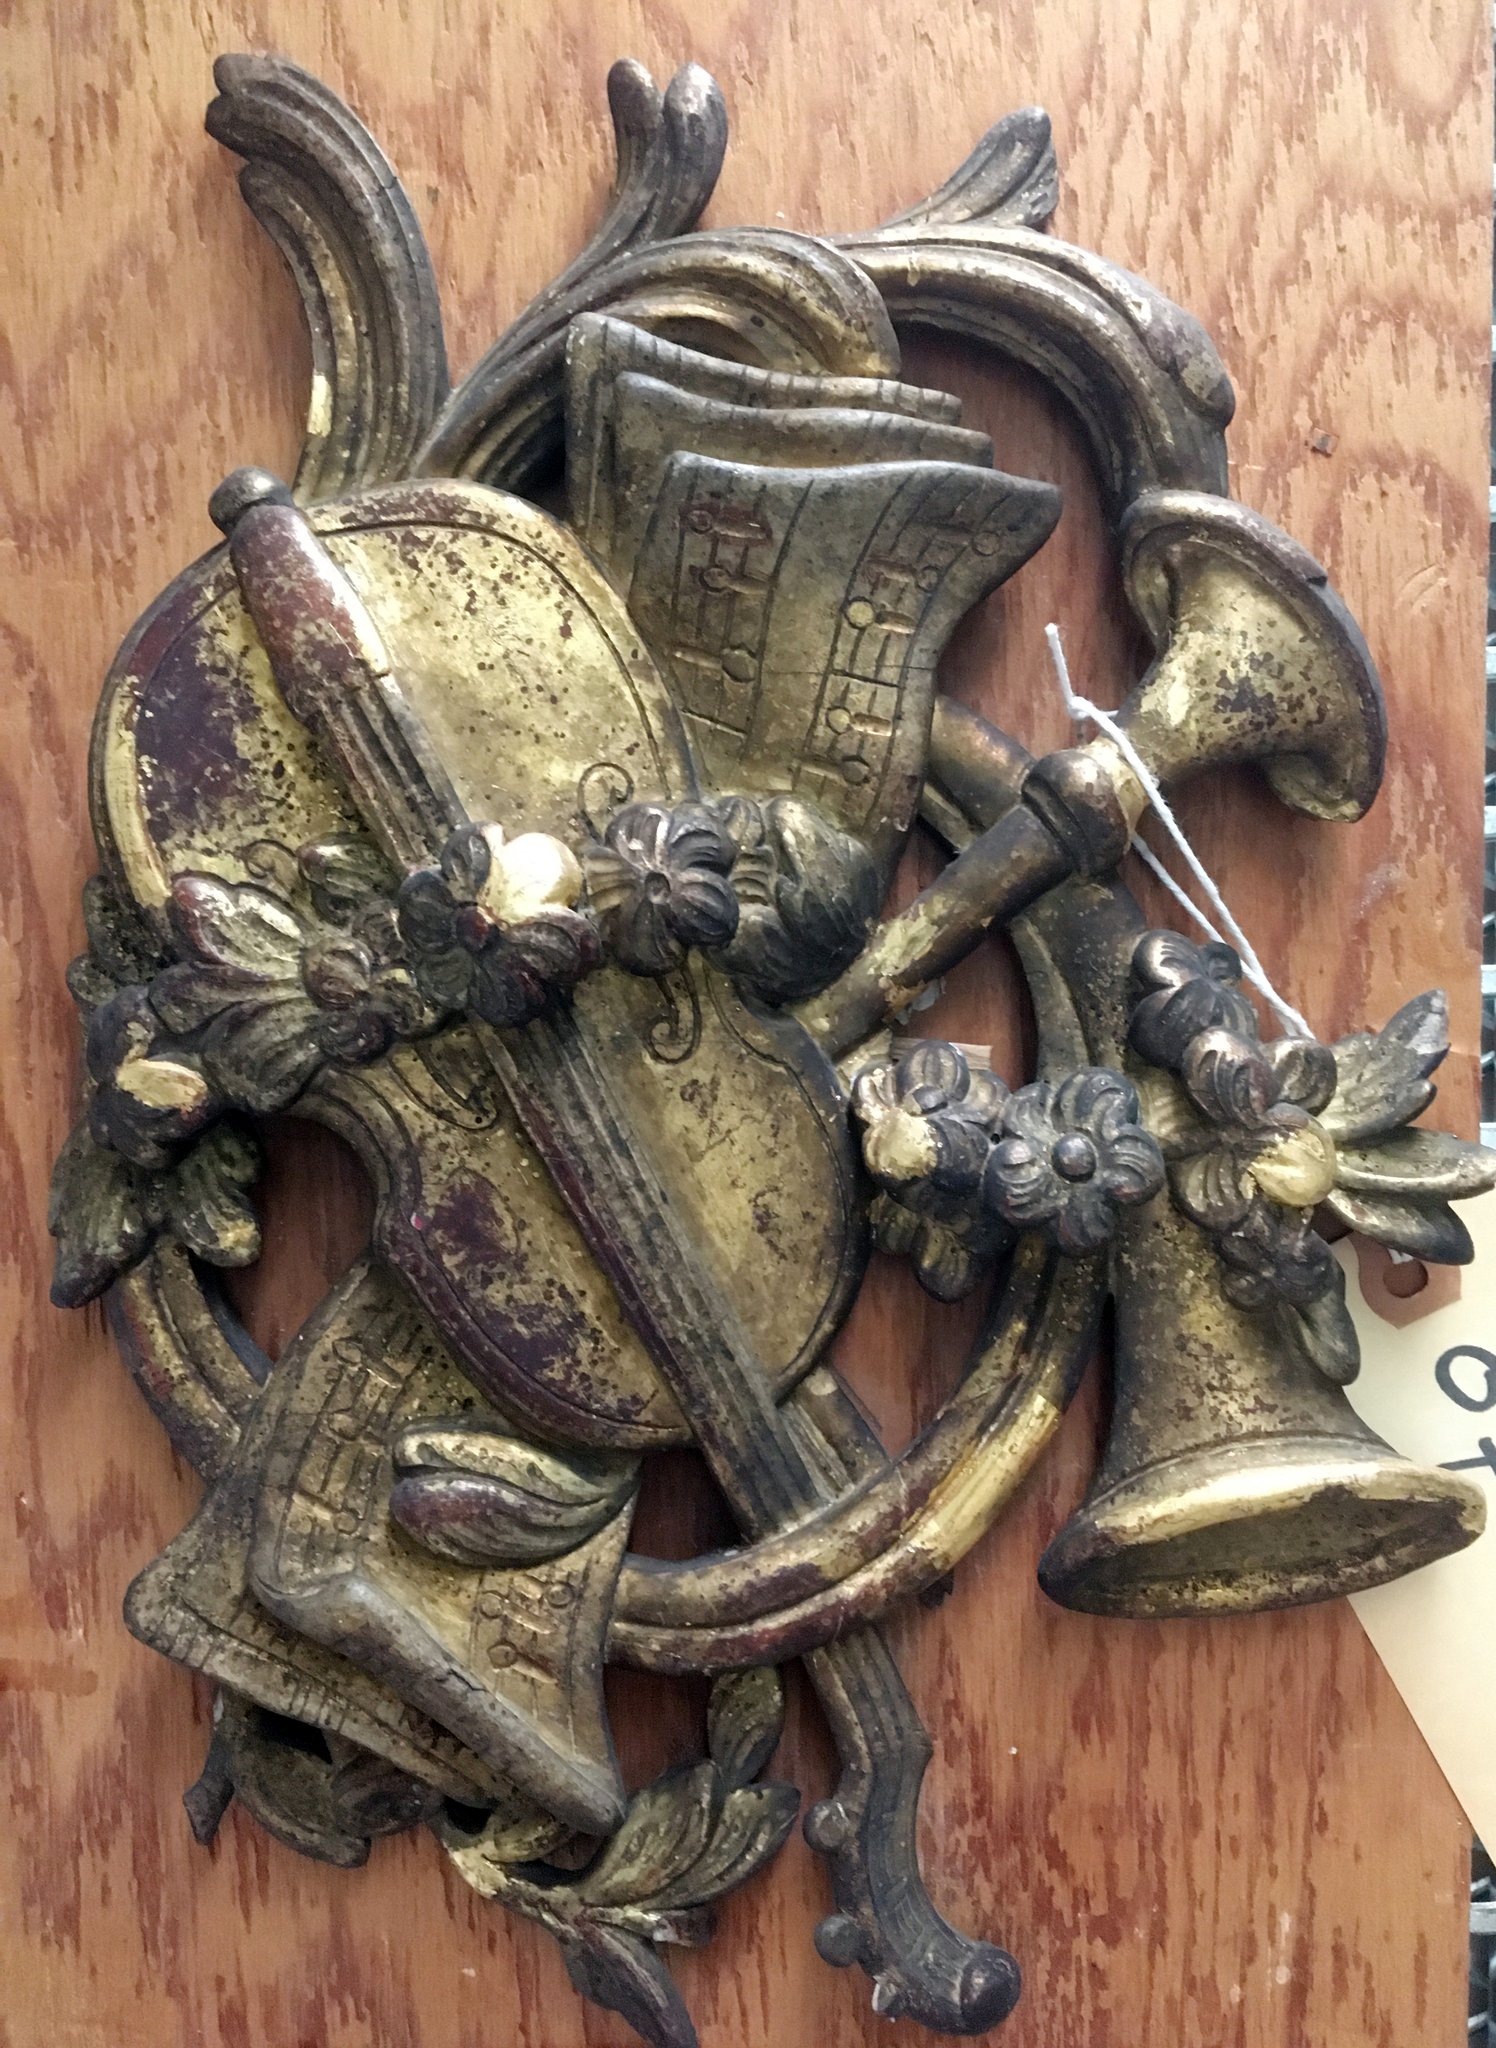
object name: trophy detail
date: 1701-1800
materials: gilt, wood